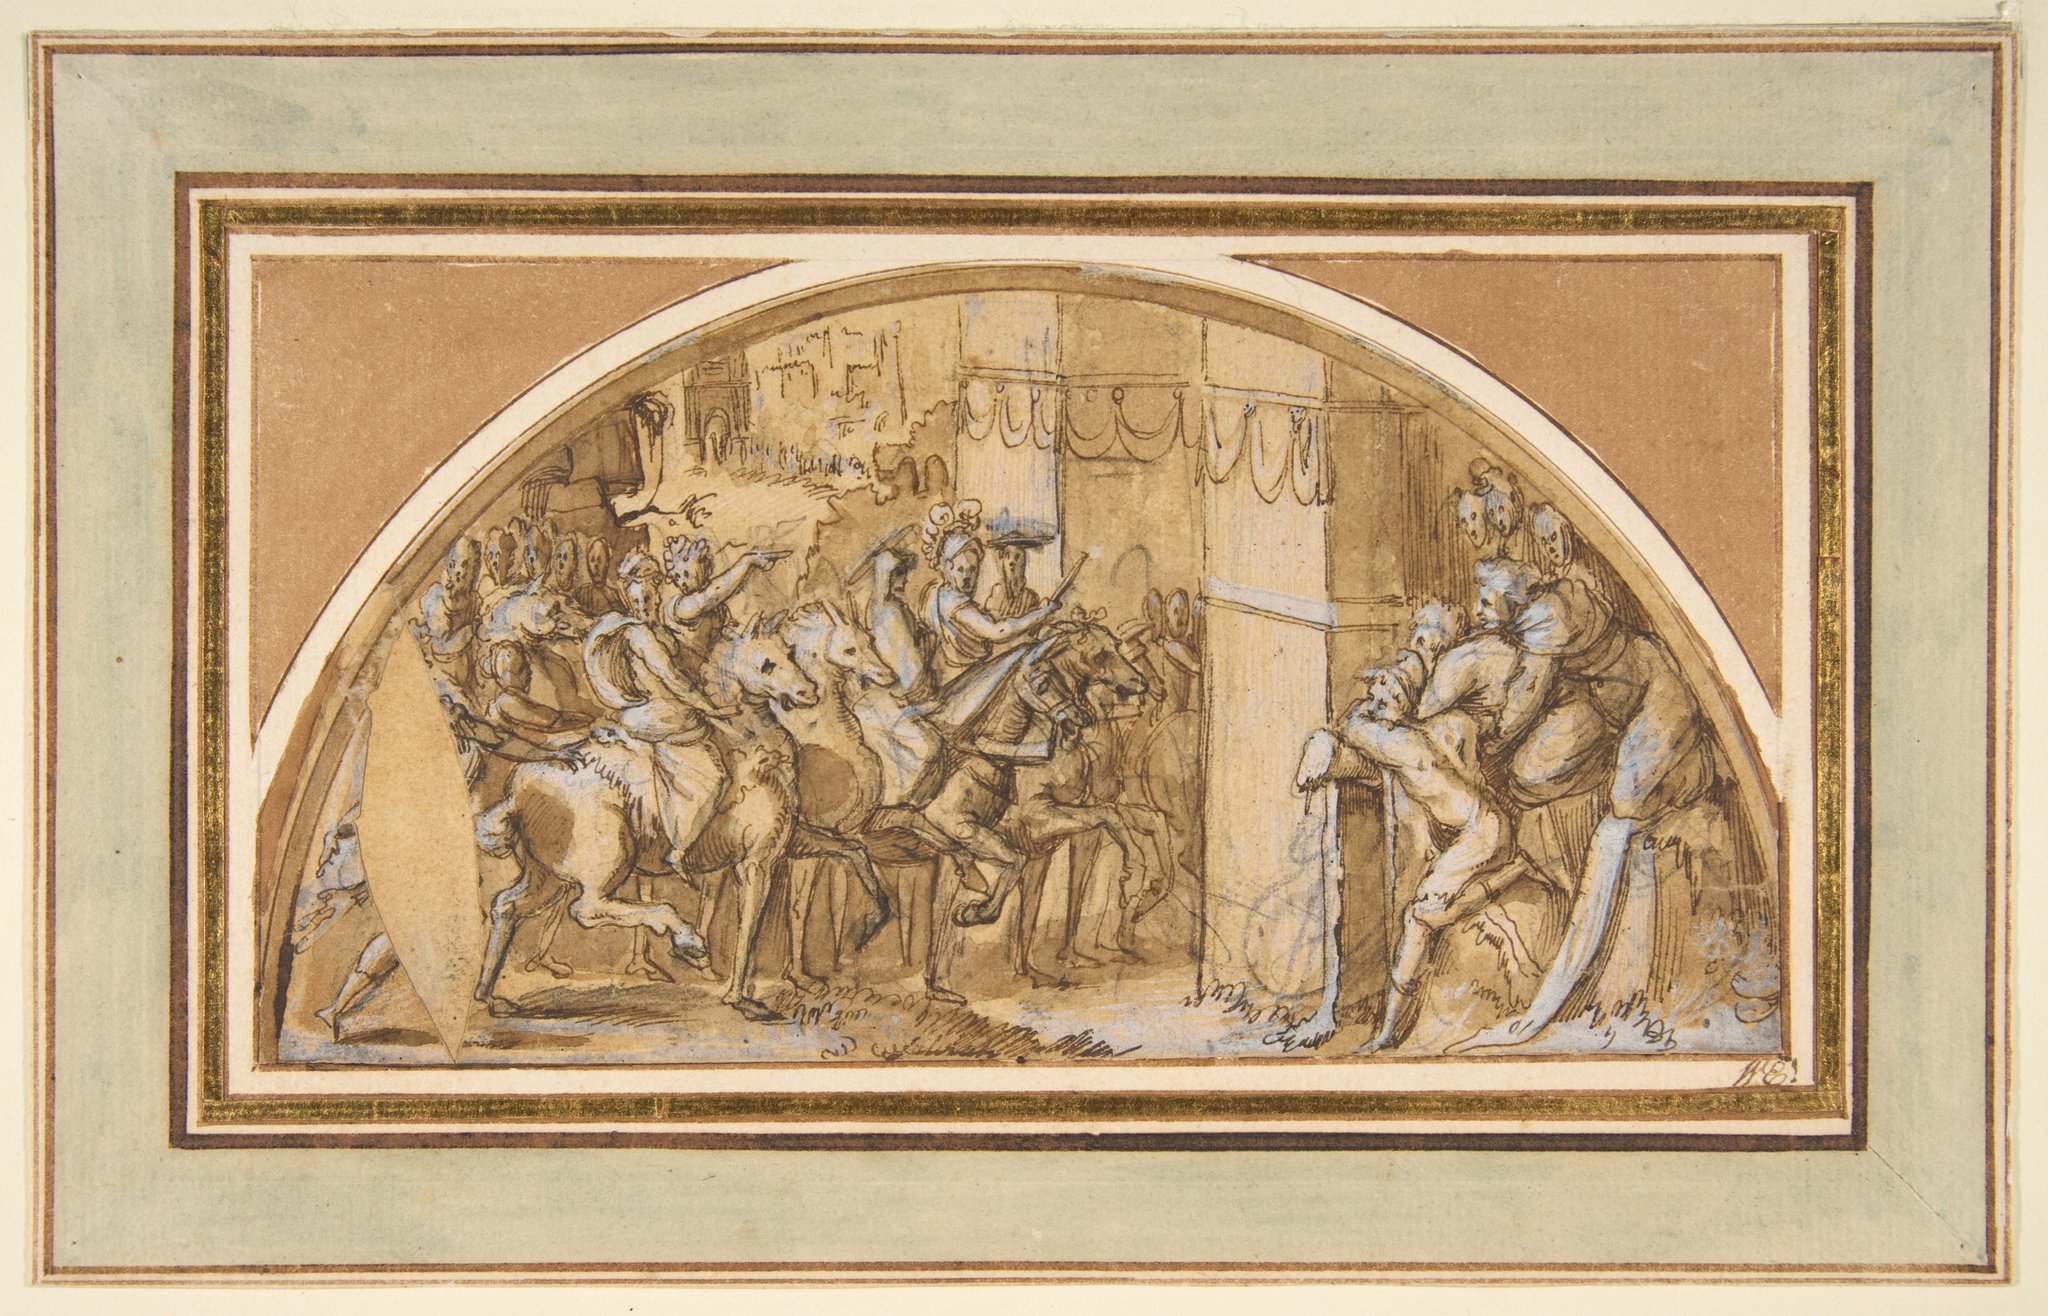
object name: drawing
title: Triumphal Entry into a City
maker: francesco salviati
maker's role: artist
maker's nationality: italian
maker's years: 1510-1563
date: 1530-1539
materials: chalk, ink, paper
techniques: brush, highlighting, pen, wash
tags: cities,men,horses